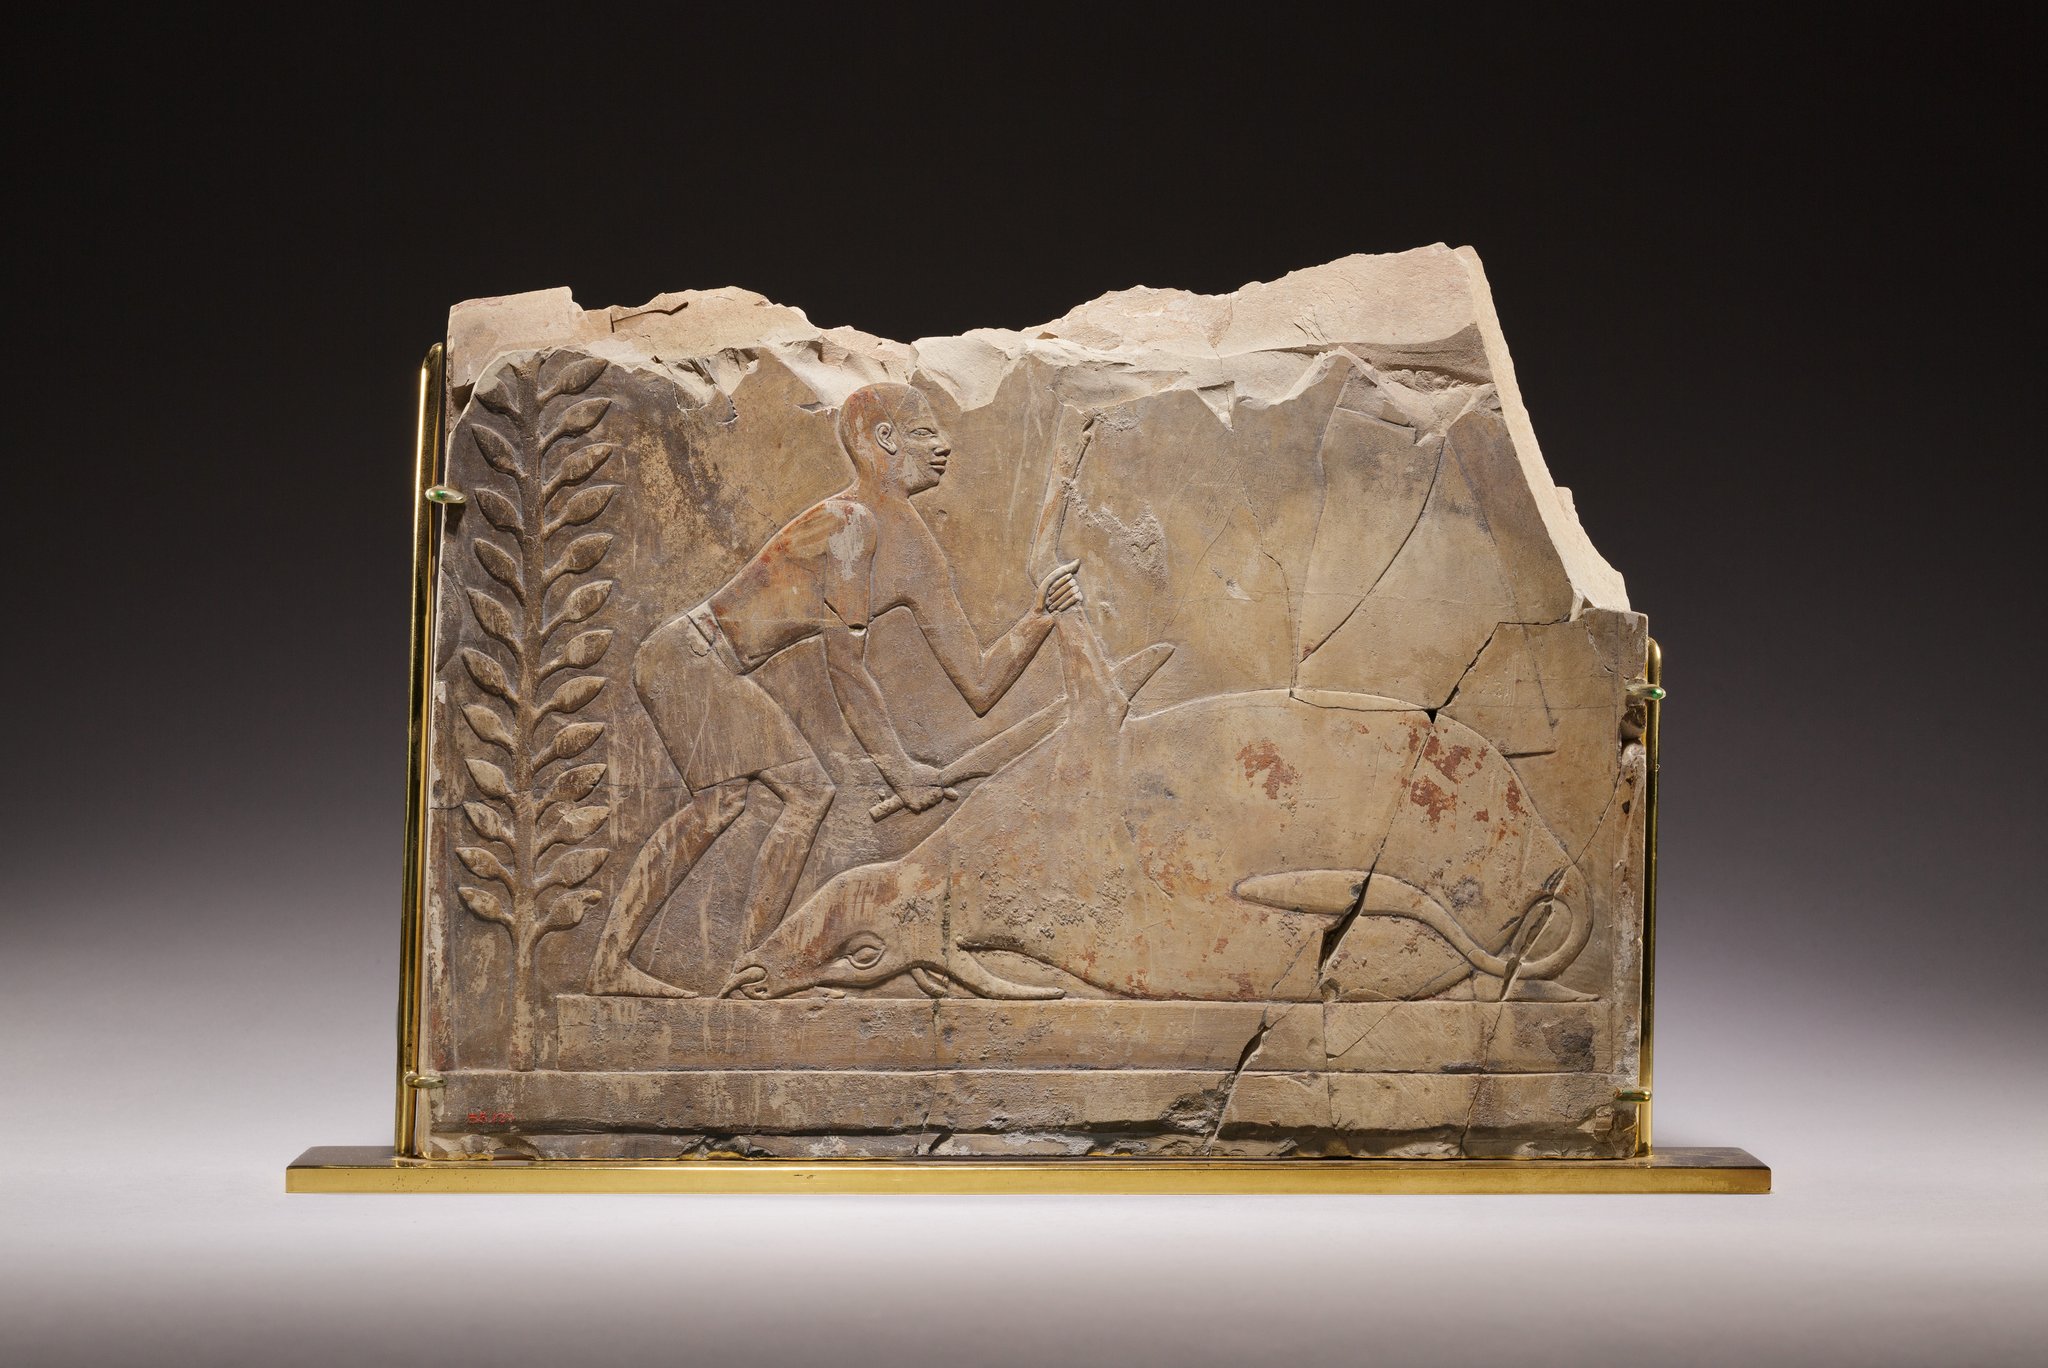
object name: relief, slaughter, bull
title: Slaughtering a bull as part of funeral rites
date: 690-645 BCE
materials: limestone, paint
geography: egypt